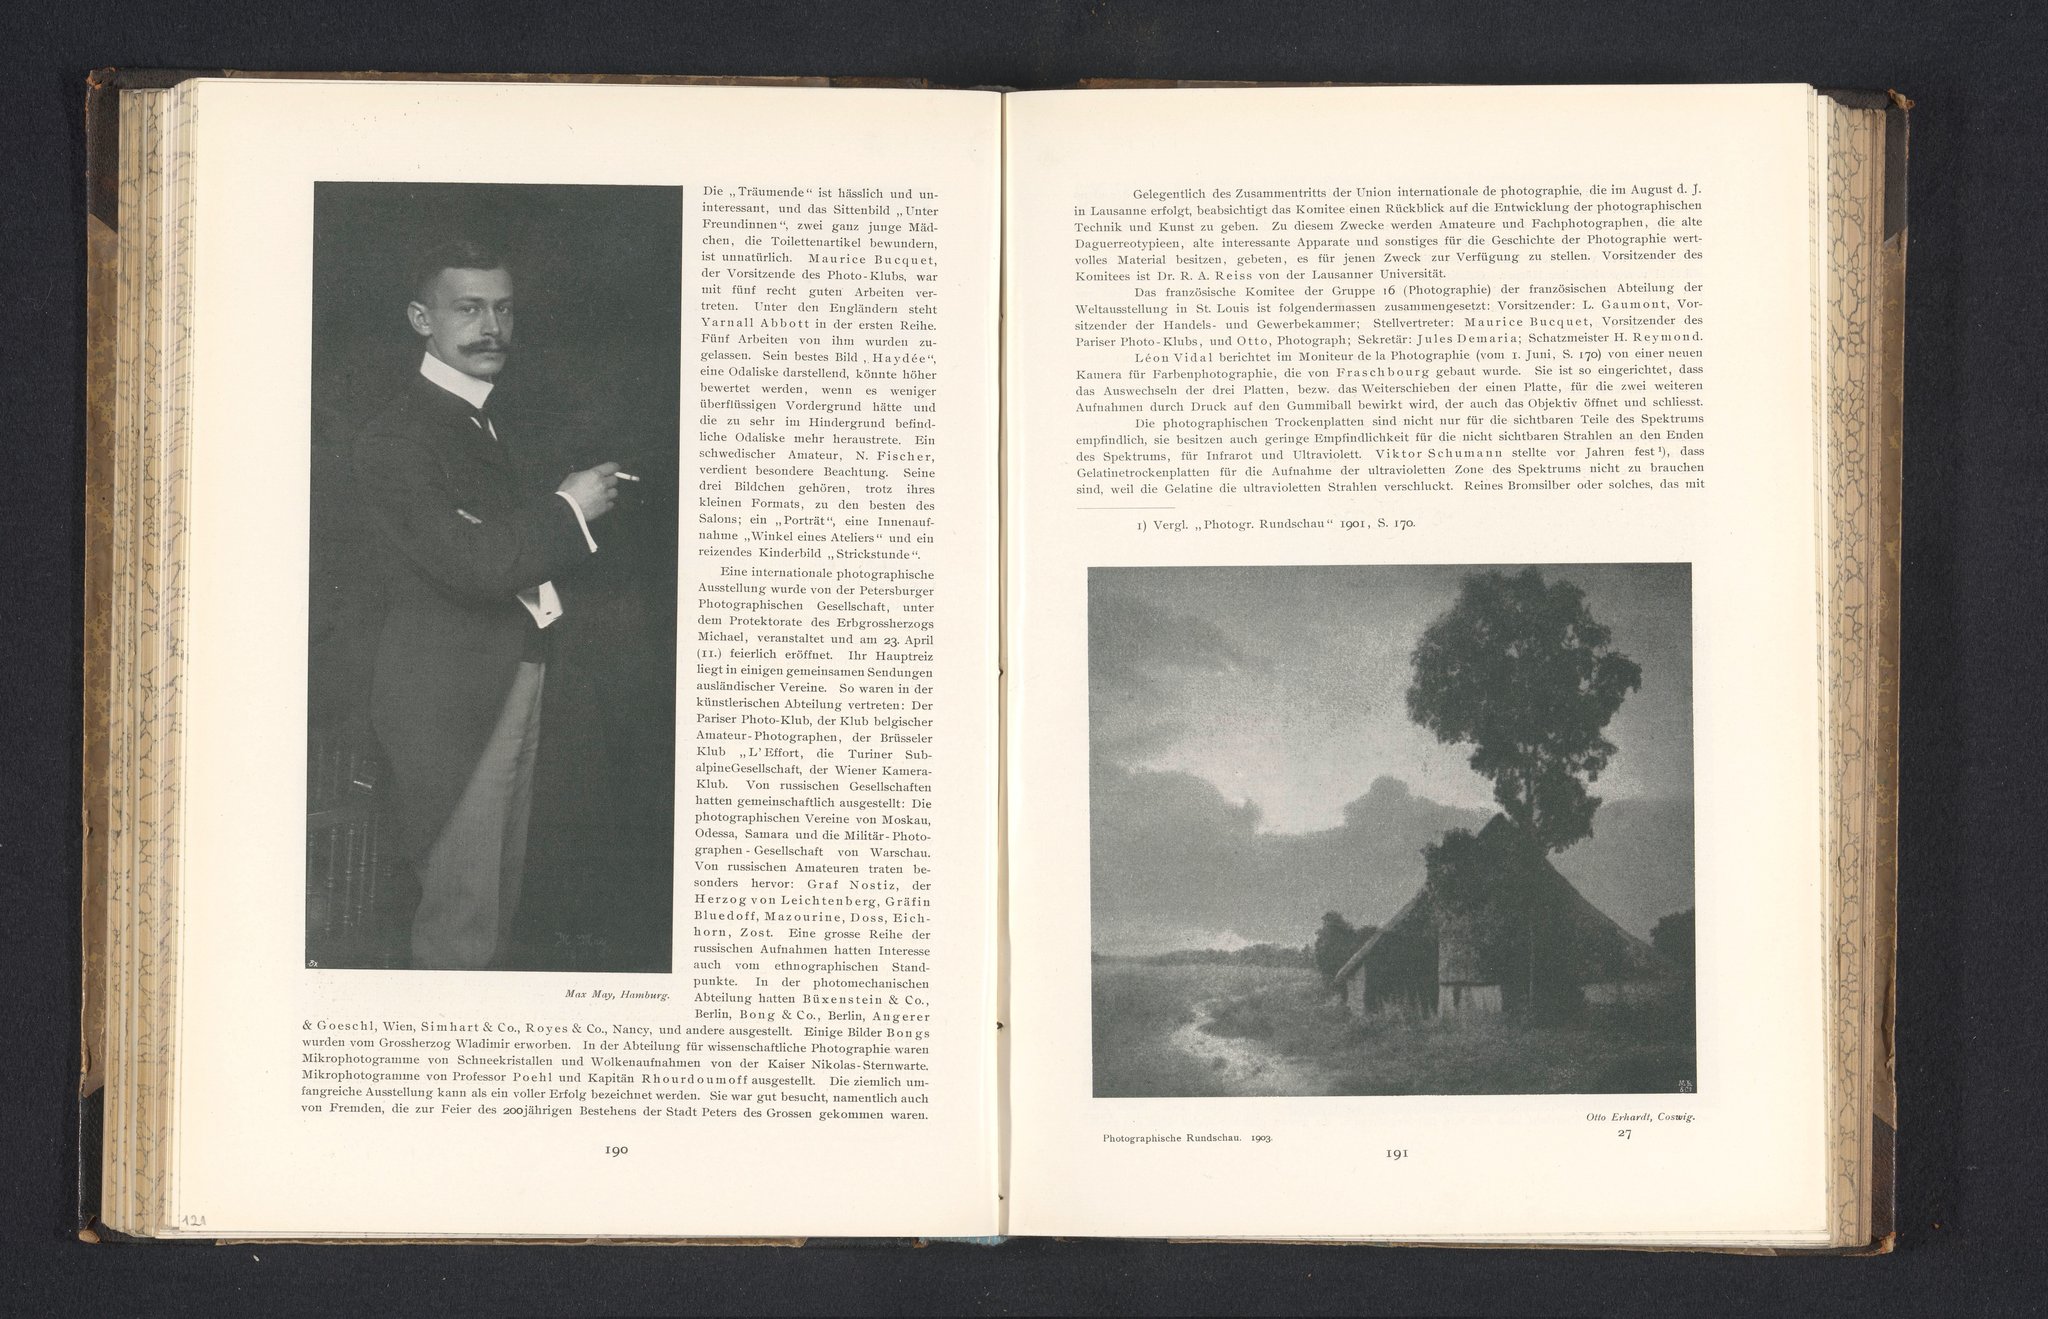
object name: page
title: Gezicht op een huis op het platteland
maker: otto erhardt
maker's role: fotograaf, leraar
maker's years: 1869-1942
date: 1898-1903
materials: paper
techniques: autotype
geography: berlin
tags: rural housing, e.g. country-house, villa, cottage